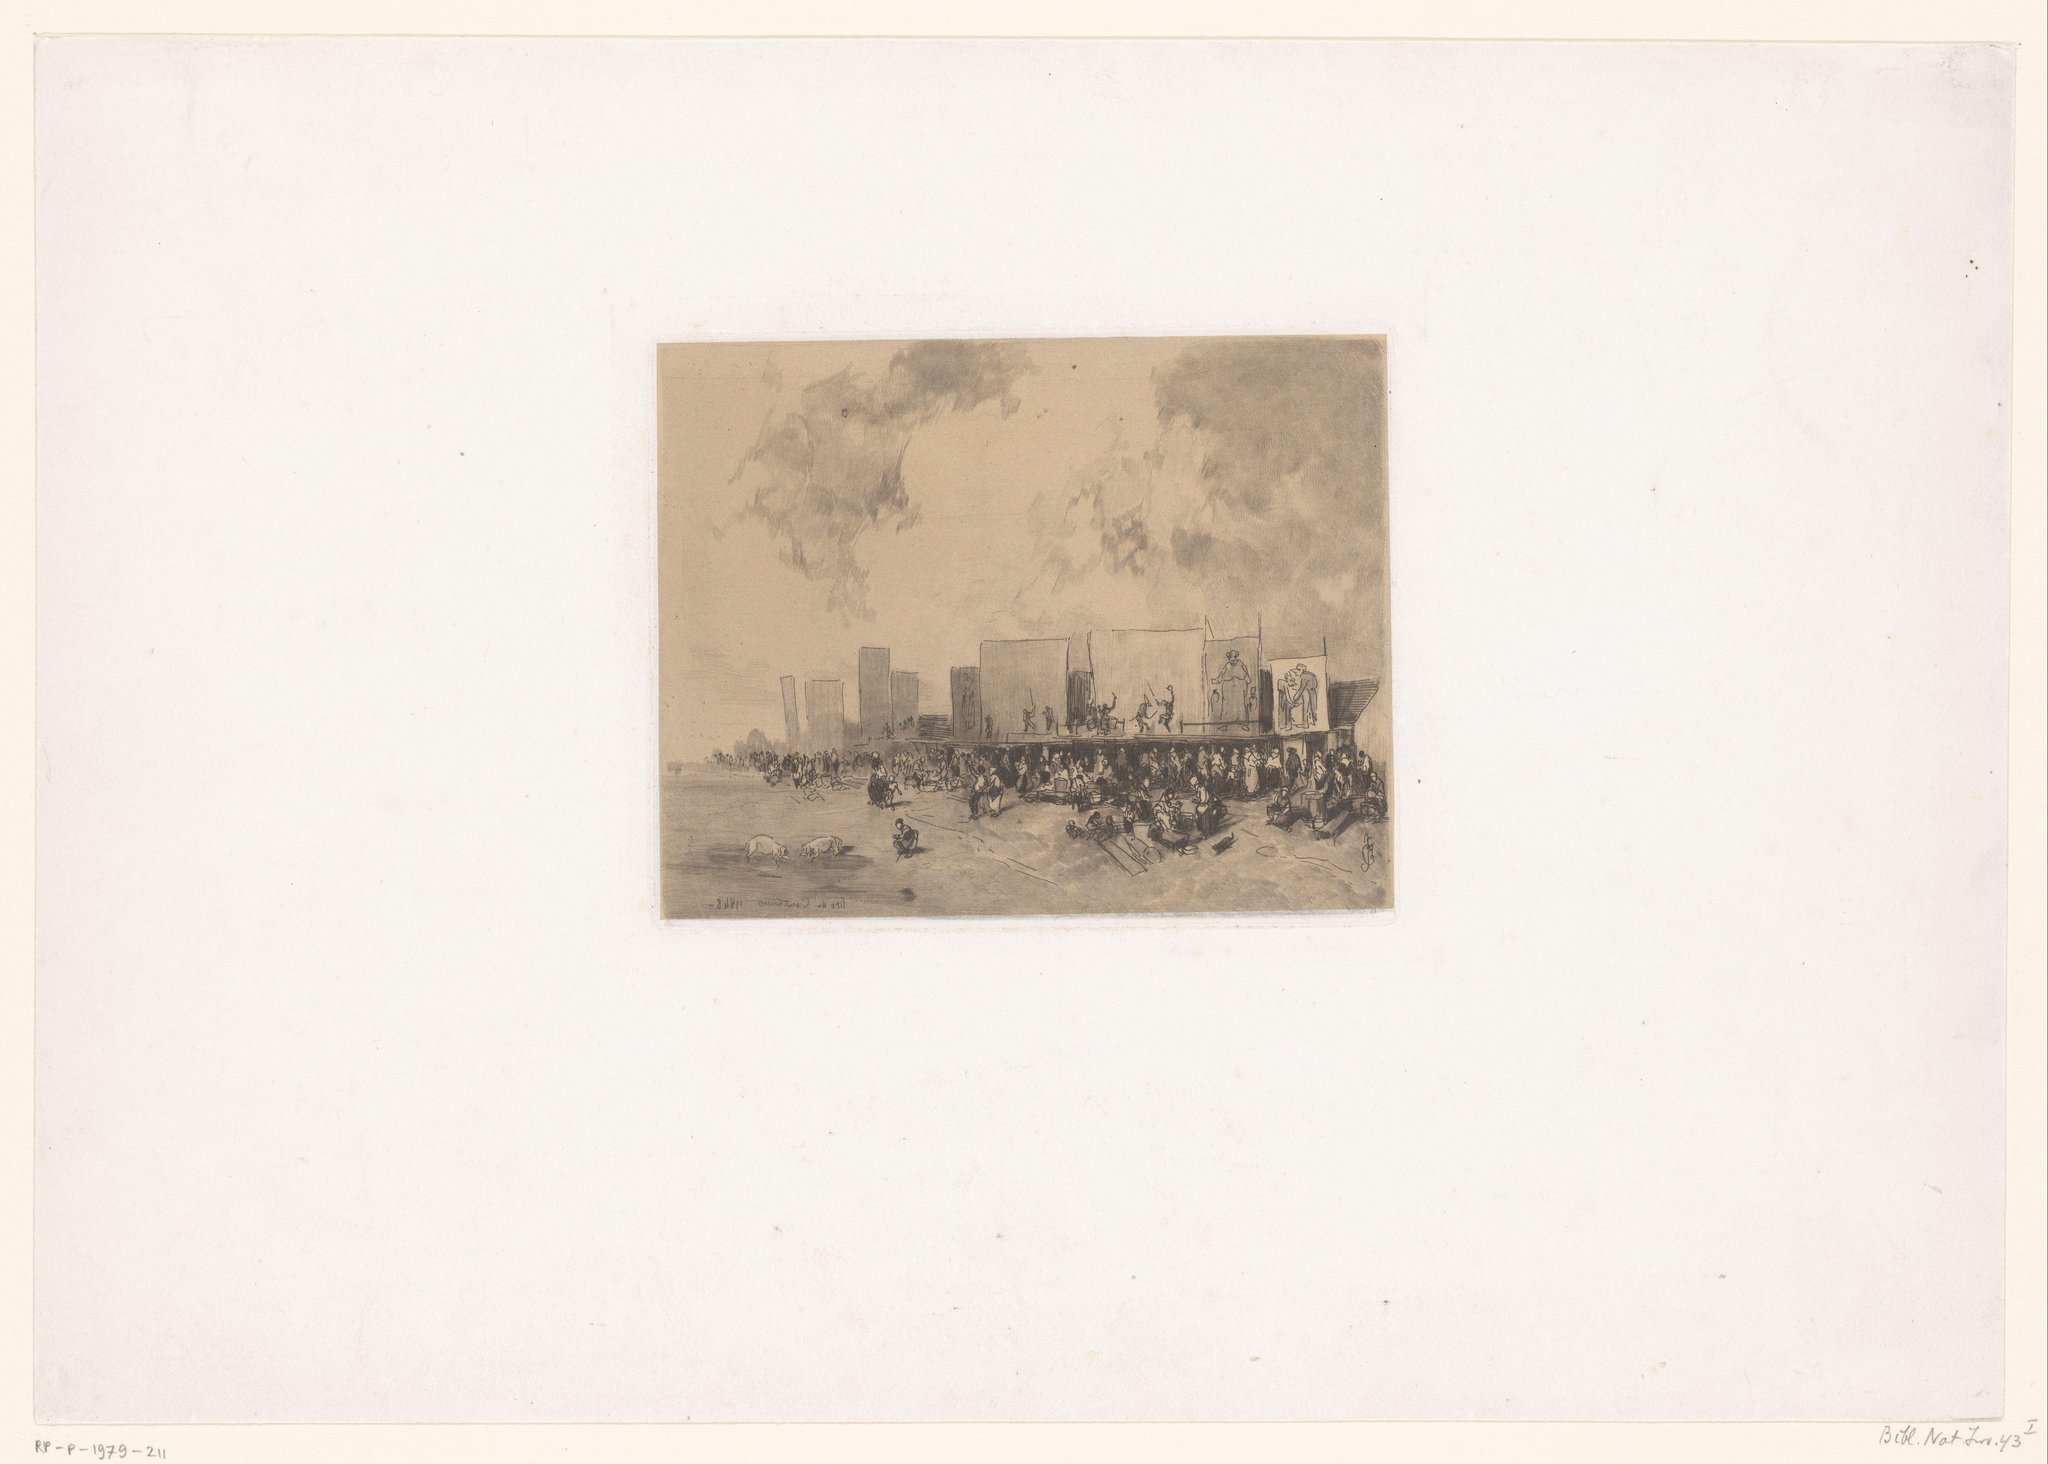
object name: print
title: 6 Eaux-fortes par Hervier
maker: louis-adolphe hervier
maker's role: draughtsman, painter, print maker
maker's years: 1818-1879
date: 1848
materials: paper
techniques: etching, roulette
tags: public festivities, village (+ city(-scape) with figures, staffage), beach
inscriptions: collector's mark: Lugt 2228, collector's mark: Lugt 2760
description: Maakt deel uit van een zesdelige serie prenten met verschillende onderwerpen, samengesteld en uitgevoerd door Hervier.